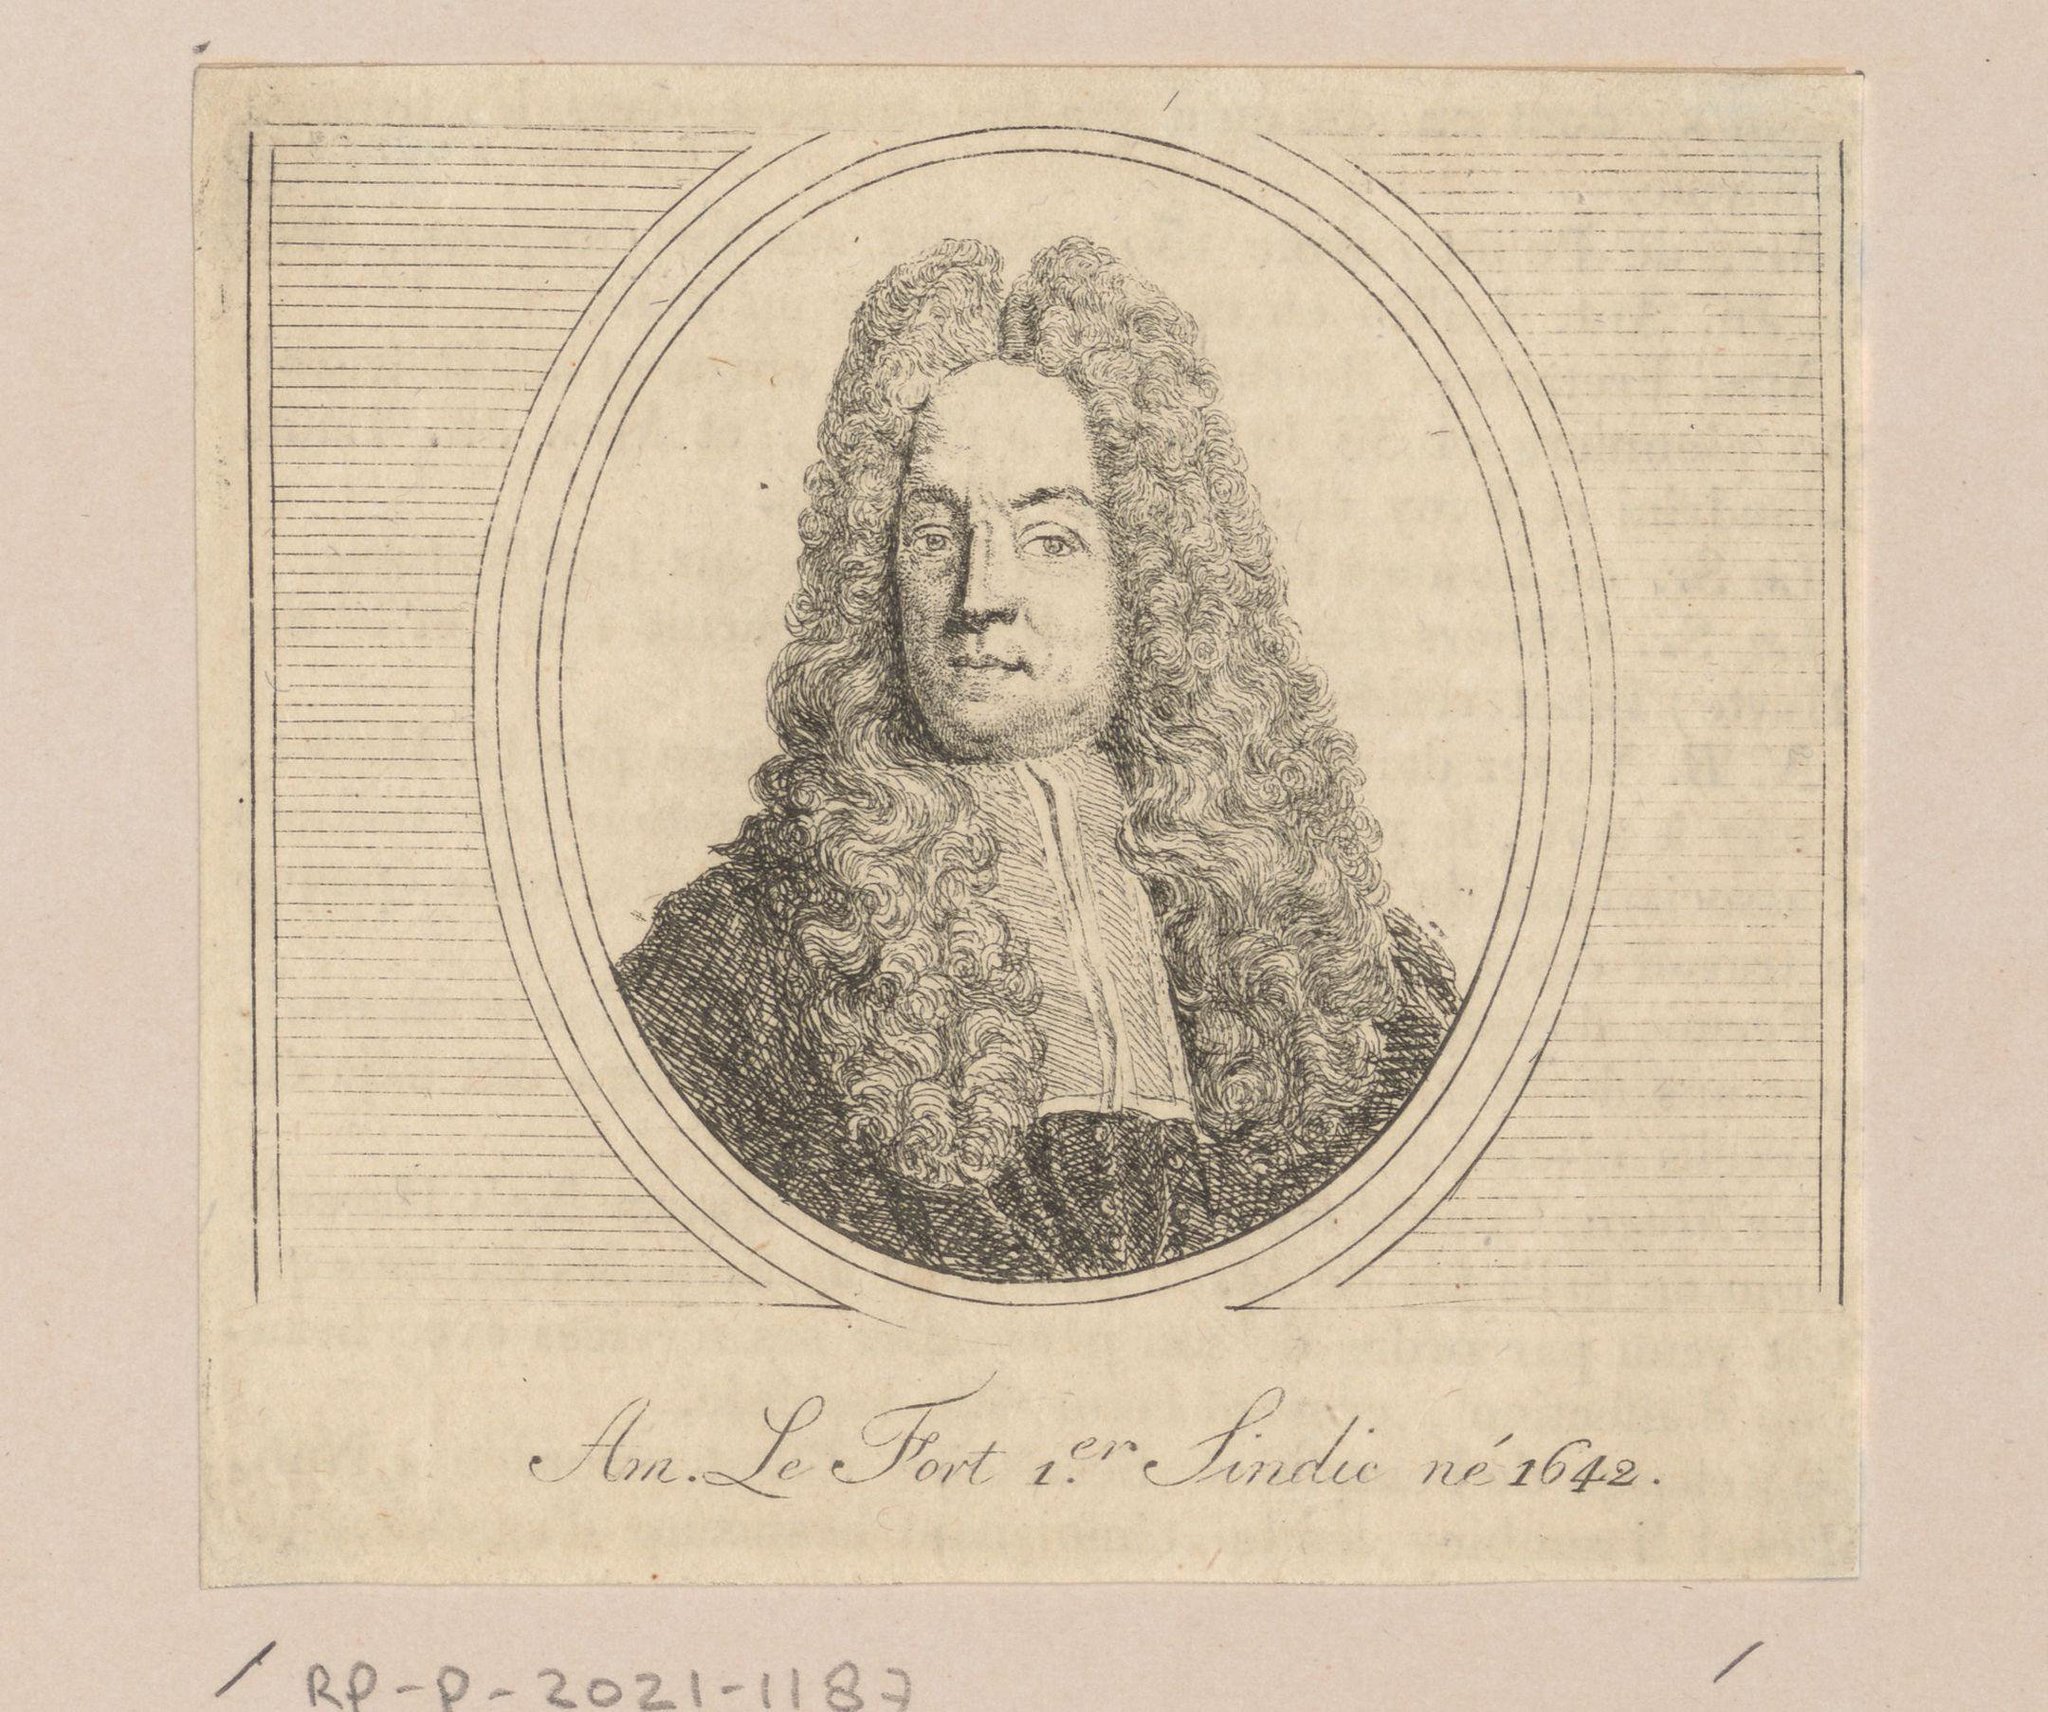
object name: print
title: Portret van Ami Le Fort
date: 1815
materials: paper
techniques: etching, letterpress printing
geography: switzerland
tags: historical persons, wig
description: Prent uit: Fragmens biographiques et historiques (...). Genève: Manget & Cherbuliez, 1815, p. 173.